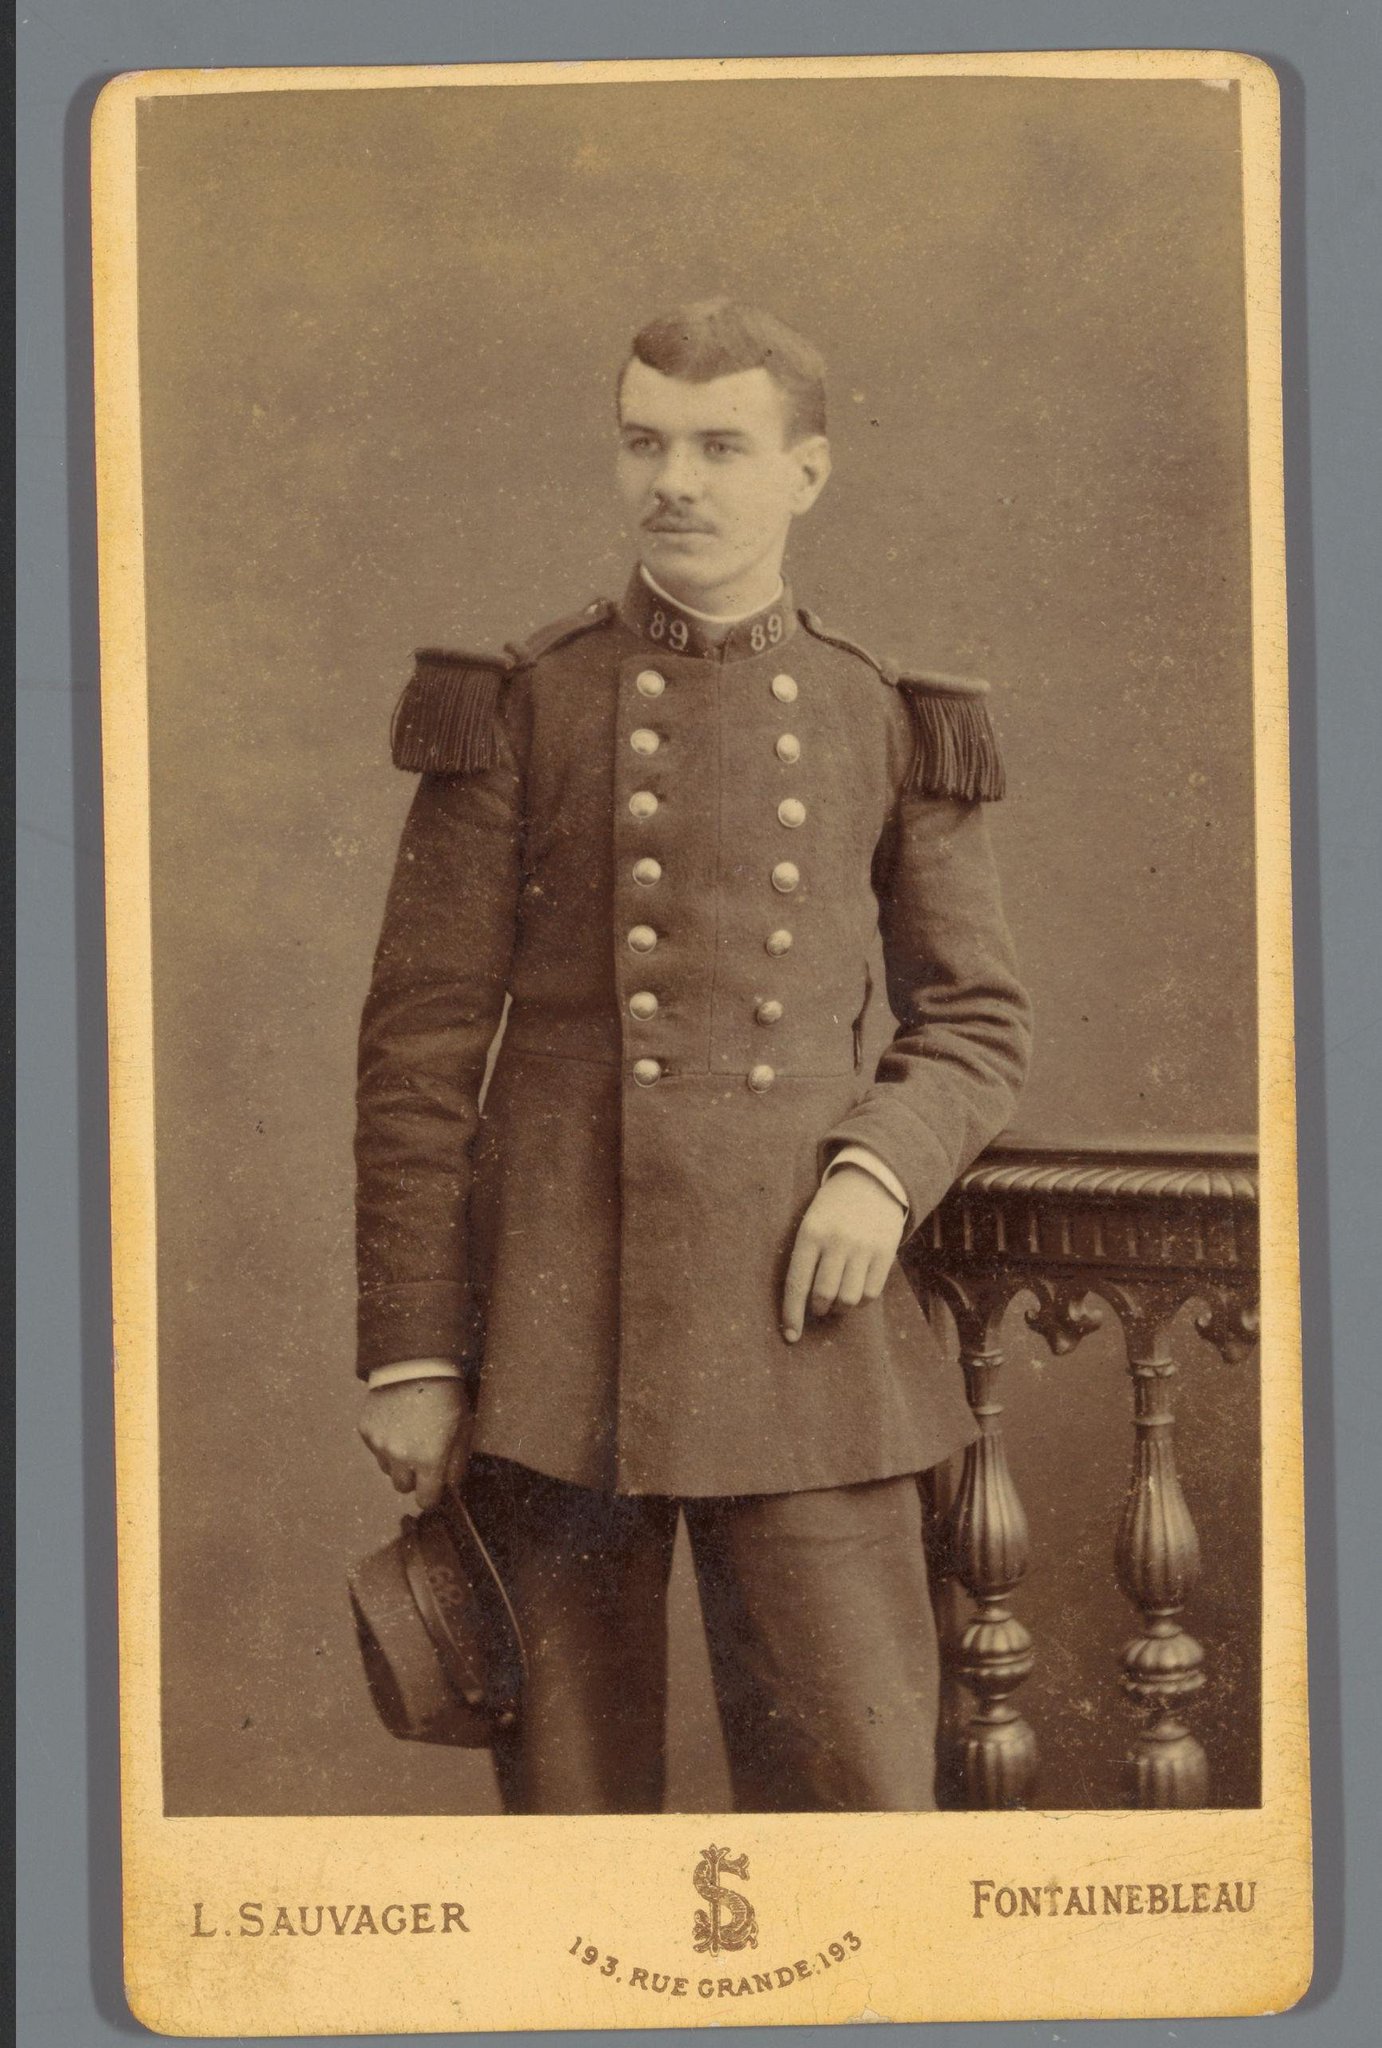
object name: carte de visite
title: Portret van een onbekende man in uniform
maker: louis sauvager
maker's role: fotograaf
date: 1880-1885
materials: cardboard, paper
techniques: albumen print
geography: fontainebleau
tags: adult man, anonymous historical person portrayed, (military) uniforms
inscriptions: address: ‘Rue Grande, 193 - Fontainebleau’, inscription: ‘MÉDAILLE A L'EXPOSITION UNIVERSELLE/ PARIS/ 1878/ MÉDAILLE D'OR/ Exposition Artsitique de Melun 1880/ NOTA. Tous les Clichés sont conservés/ et l'on peut avec ces clichés faire de Grands Portraits Inalterables’